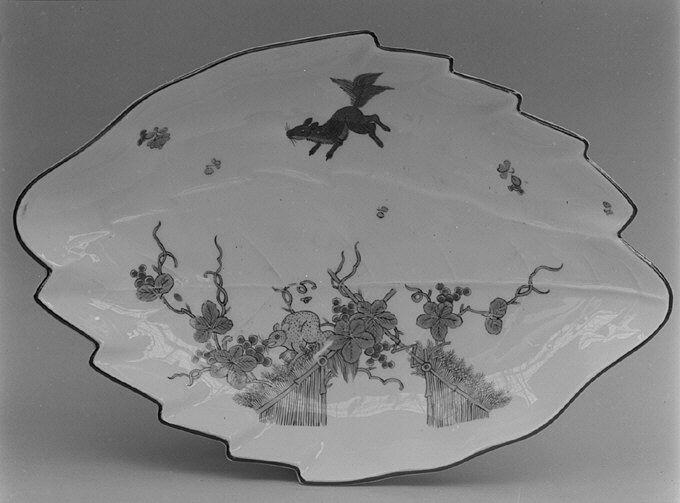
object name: dish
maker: meissen manufactory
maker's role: manufactory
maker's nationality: german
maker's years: 1710-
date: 1735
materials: hard paste porcelain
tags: mice